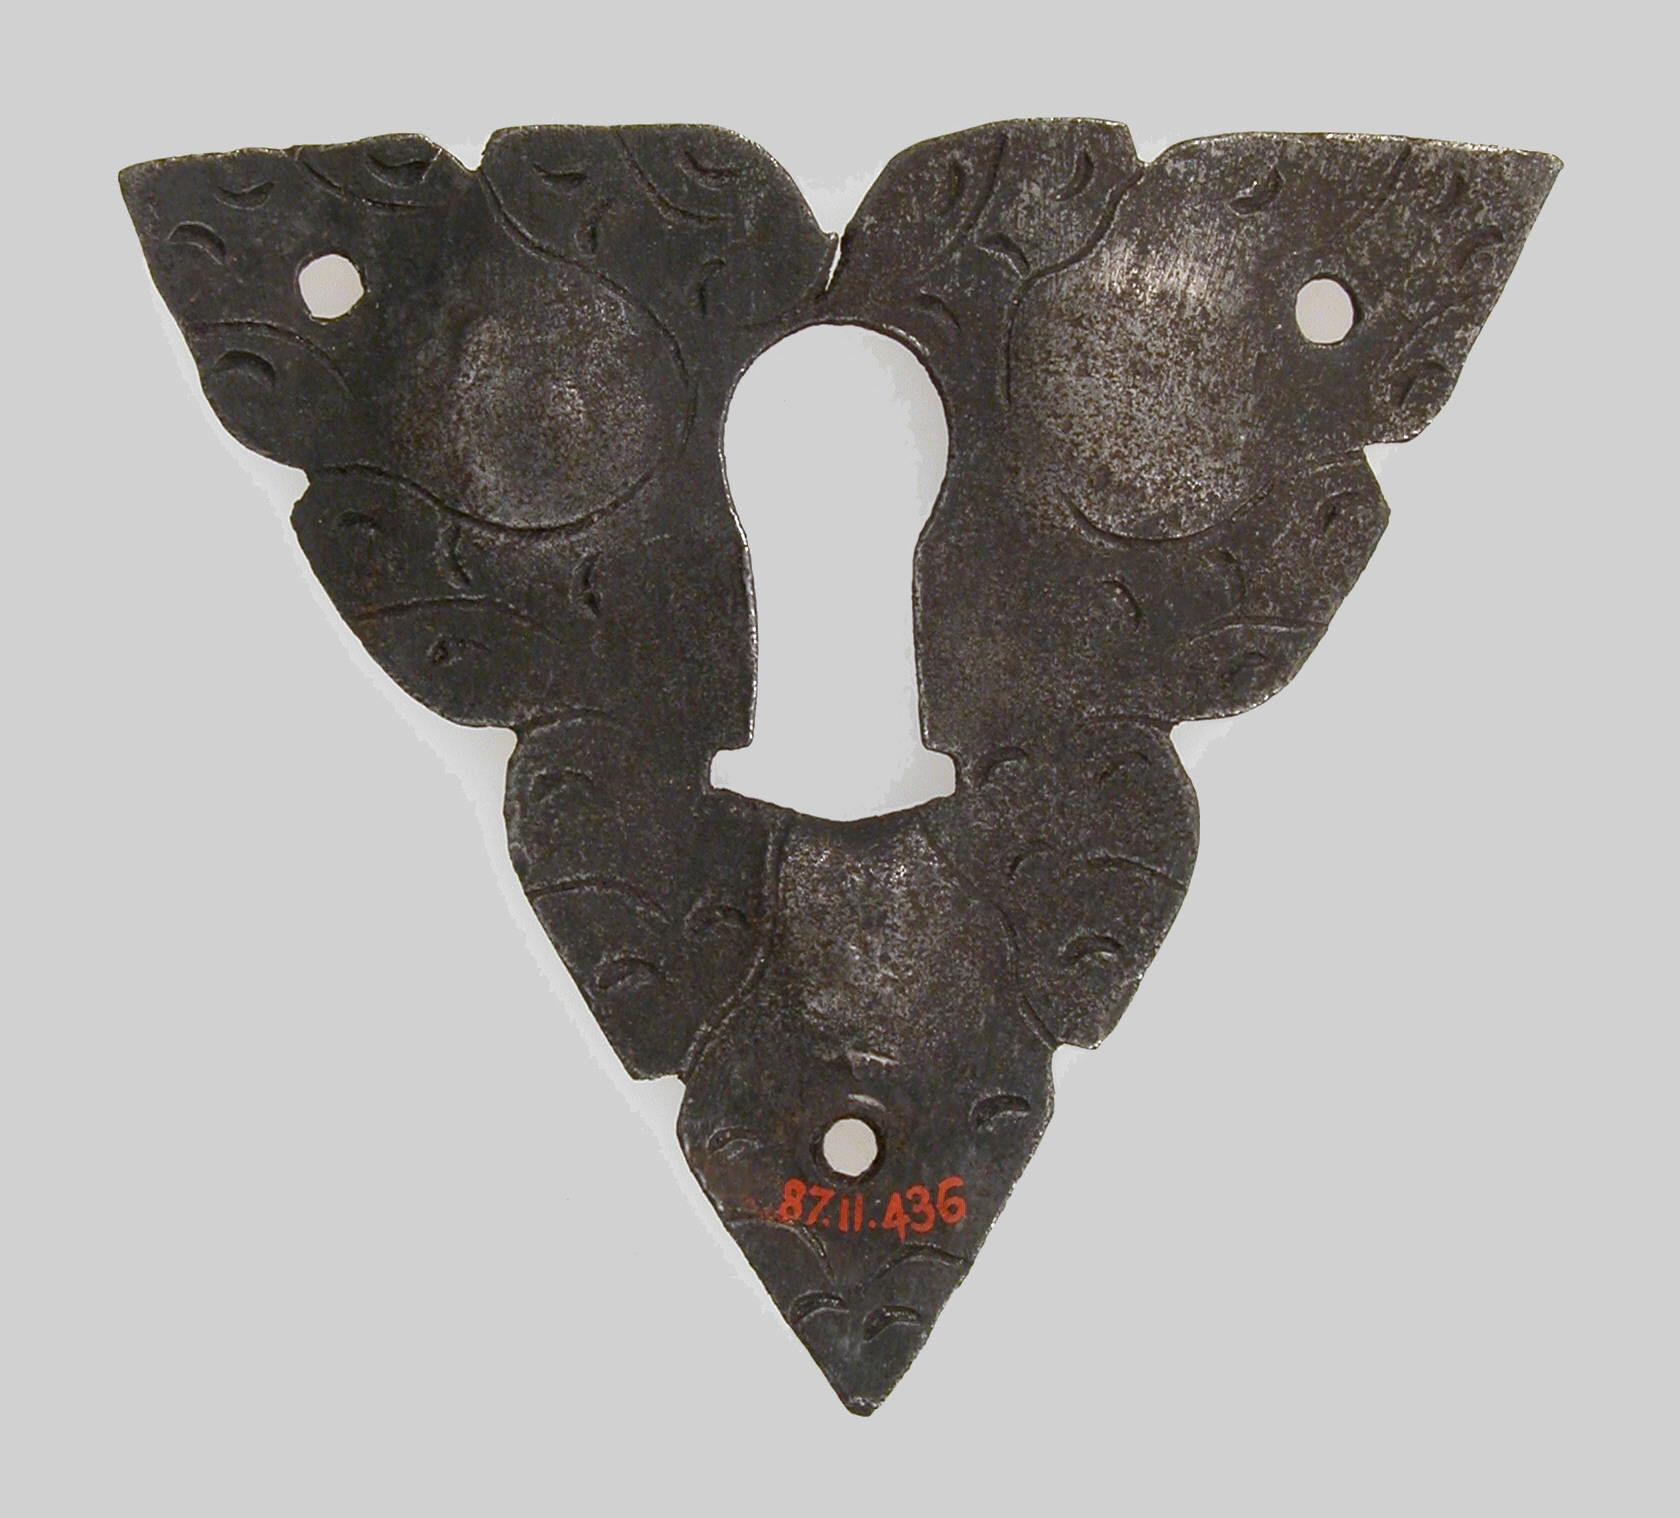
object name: escutcheon plate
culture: german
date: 1501-1600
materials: iron